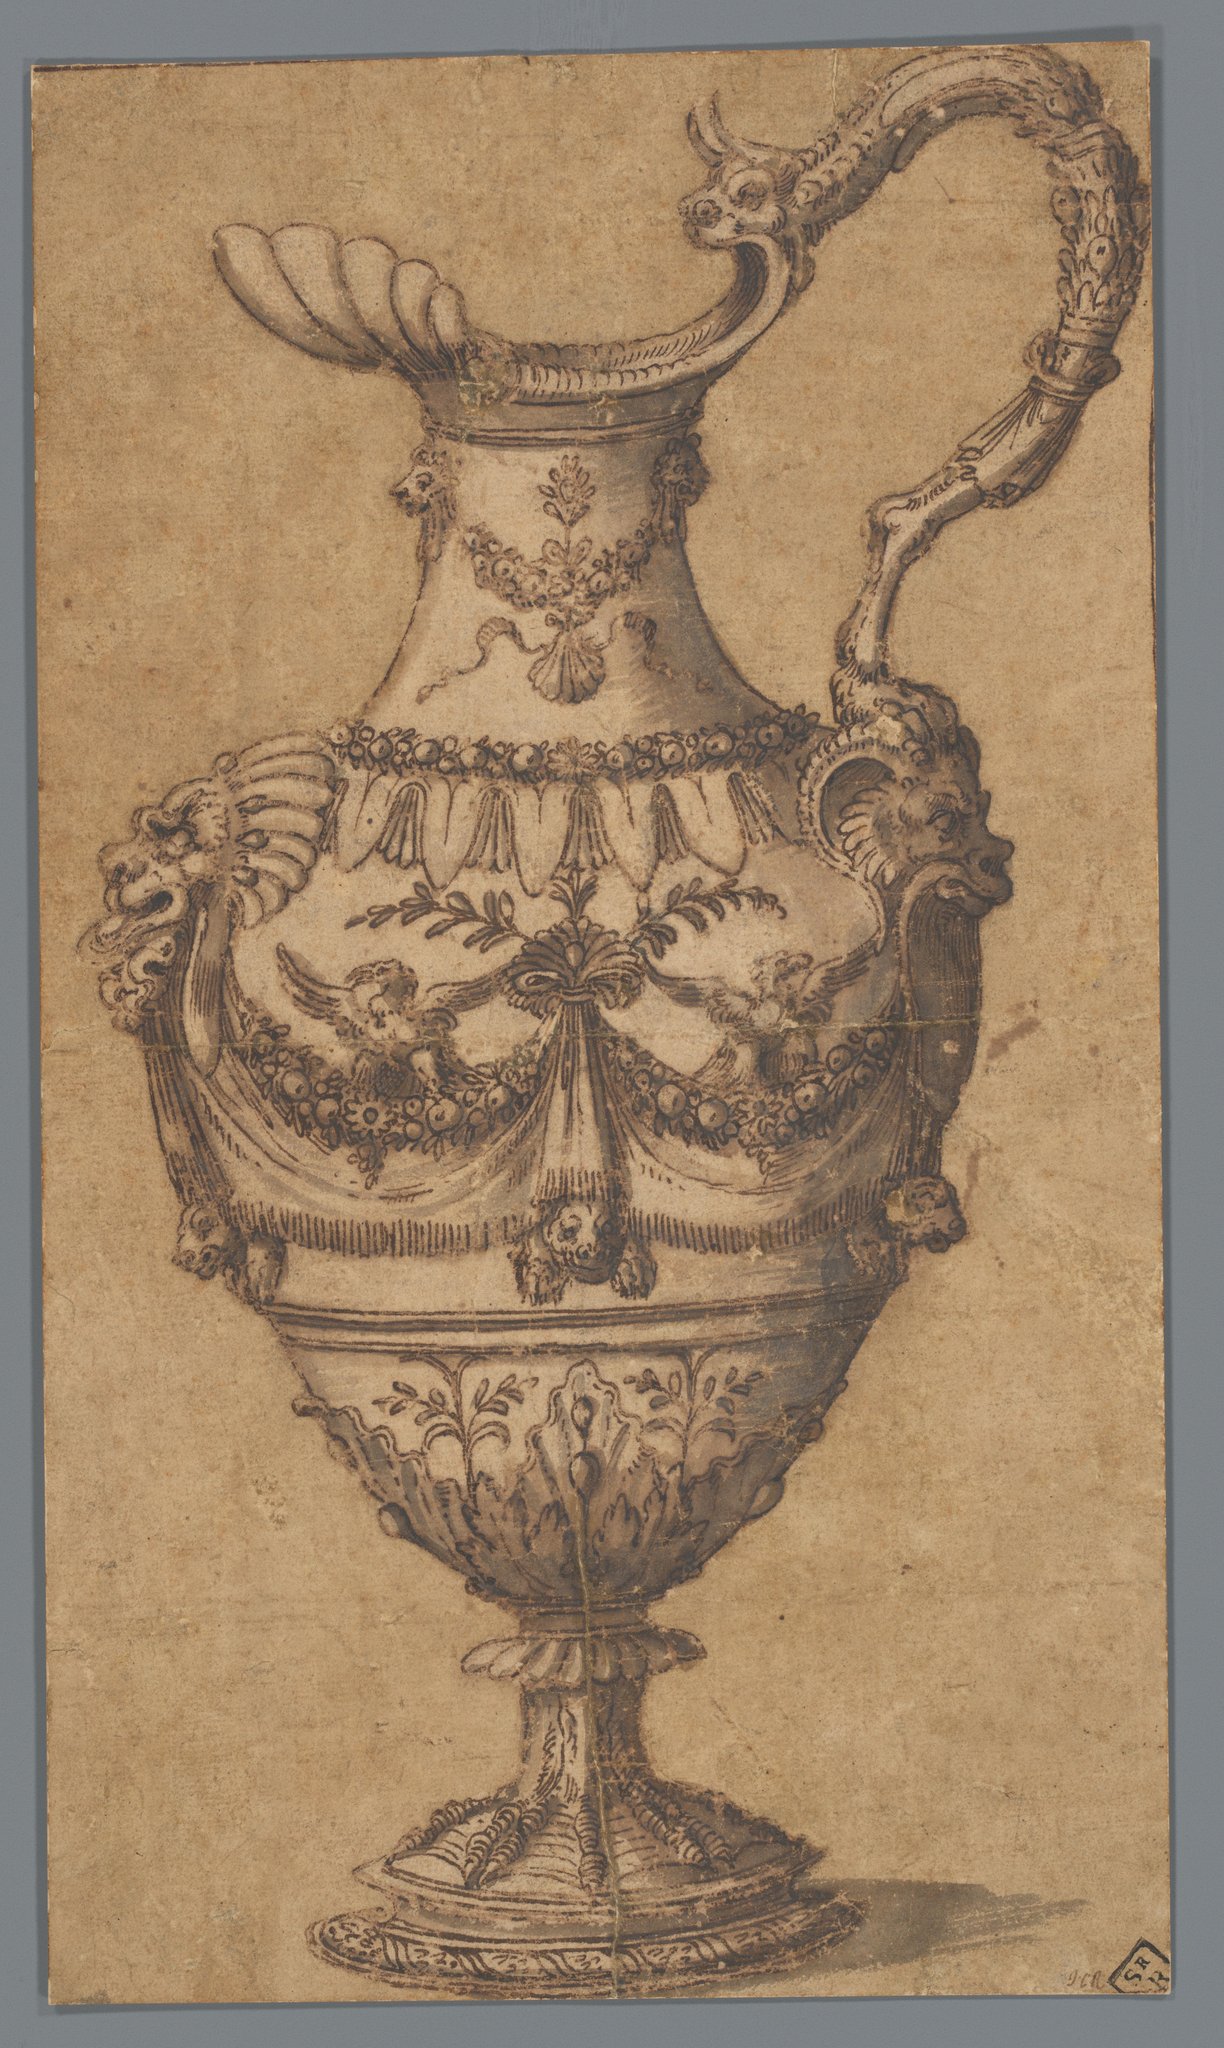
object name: design drawing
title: Ontwerp voor een kan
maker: Anonymous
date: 1550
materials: ink, paper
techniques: brush, pen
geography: italy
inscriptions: collector's mark: ‘ICR’ Lugt 1433, collector's mark: ‘SR/ IR’ Lugt 2364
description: Ontwerp voor een kan met twee maskers en een oor in de vorm van een slakkenkop.